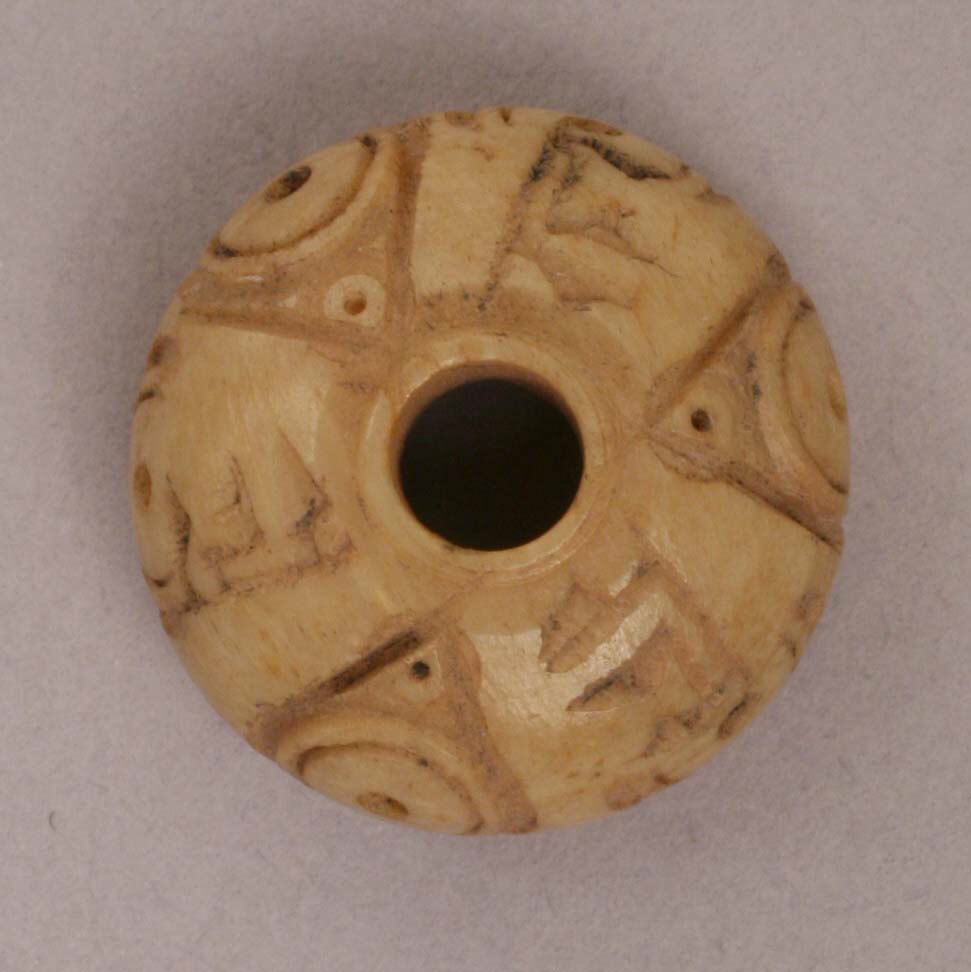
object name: button or bead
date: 801-1000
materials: bone, paint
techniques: incising, inlay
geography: iran